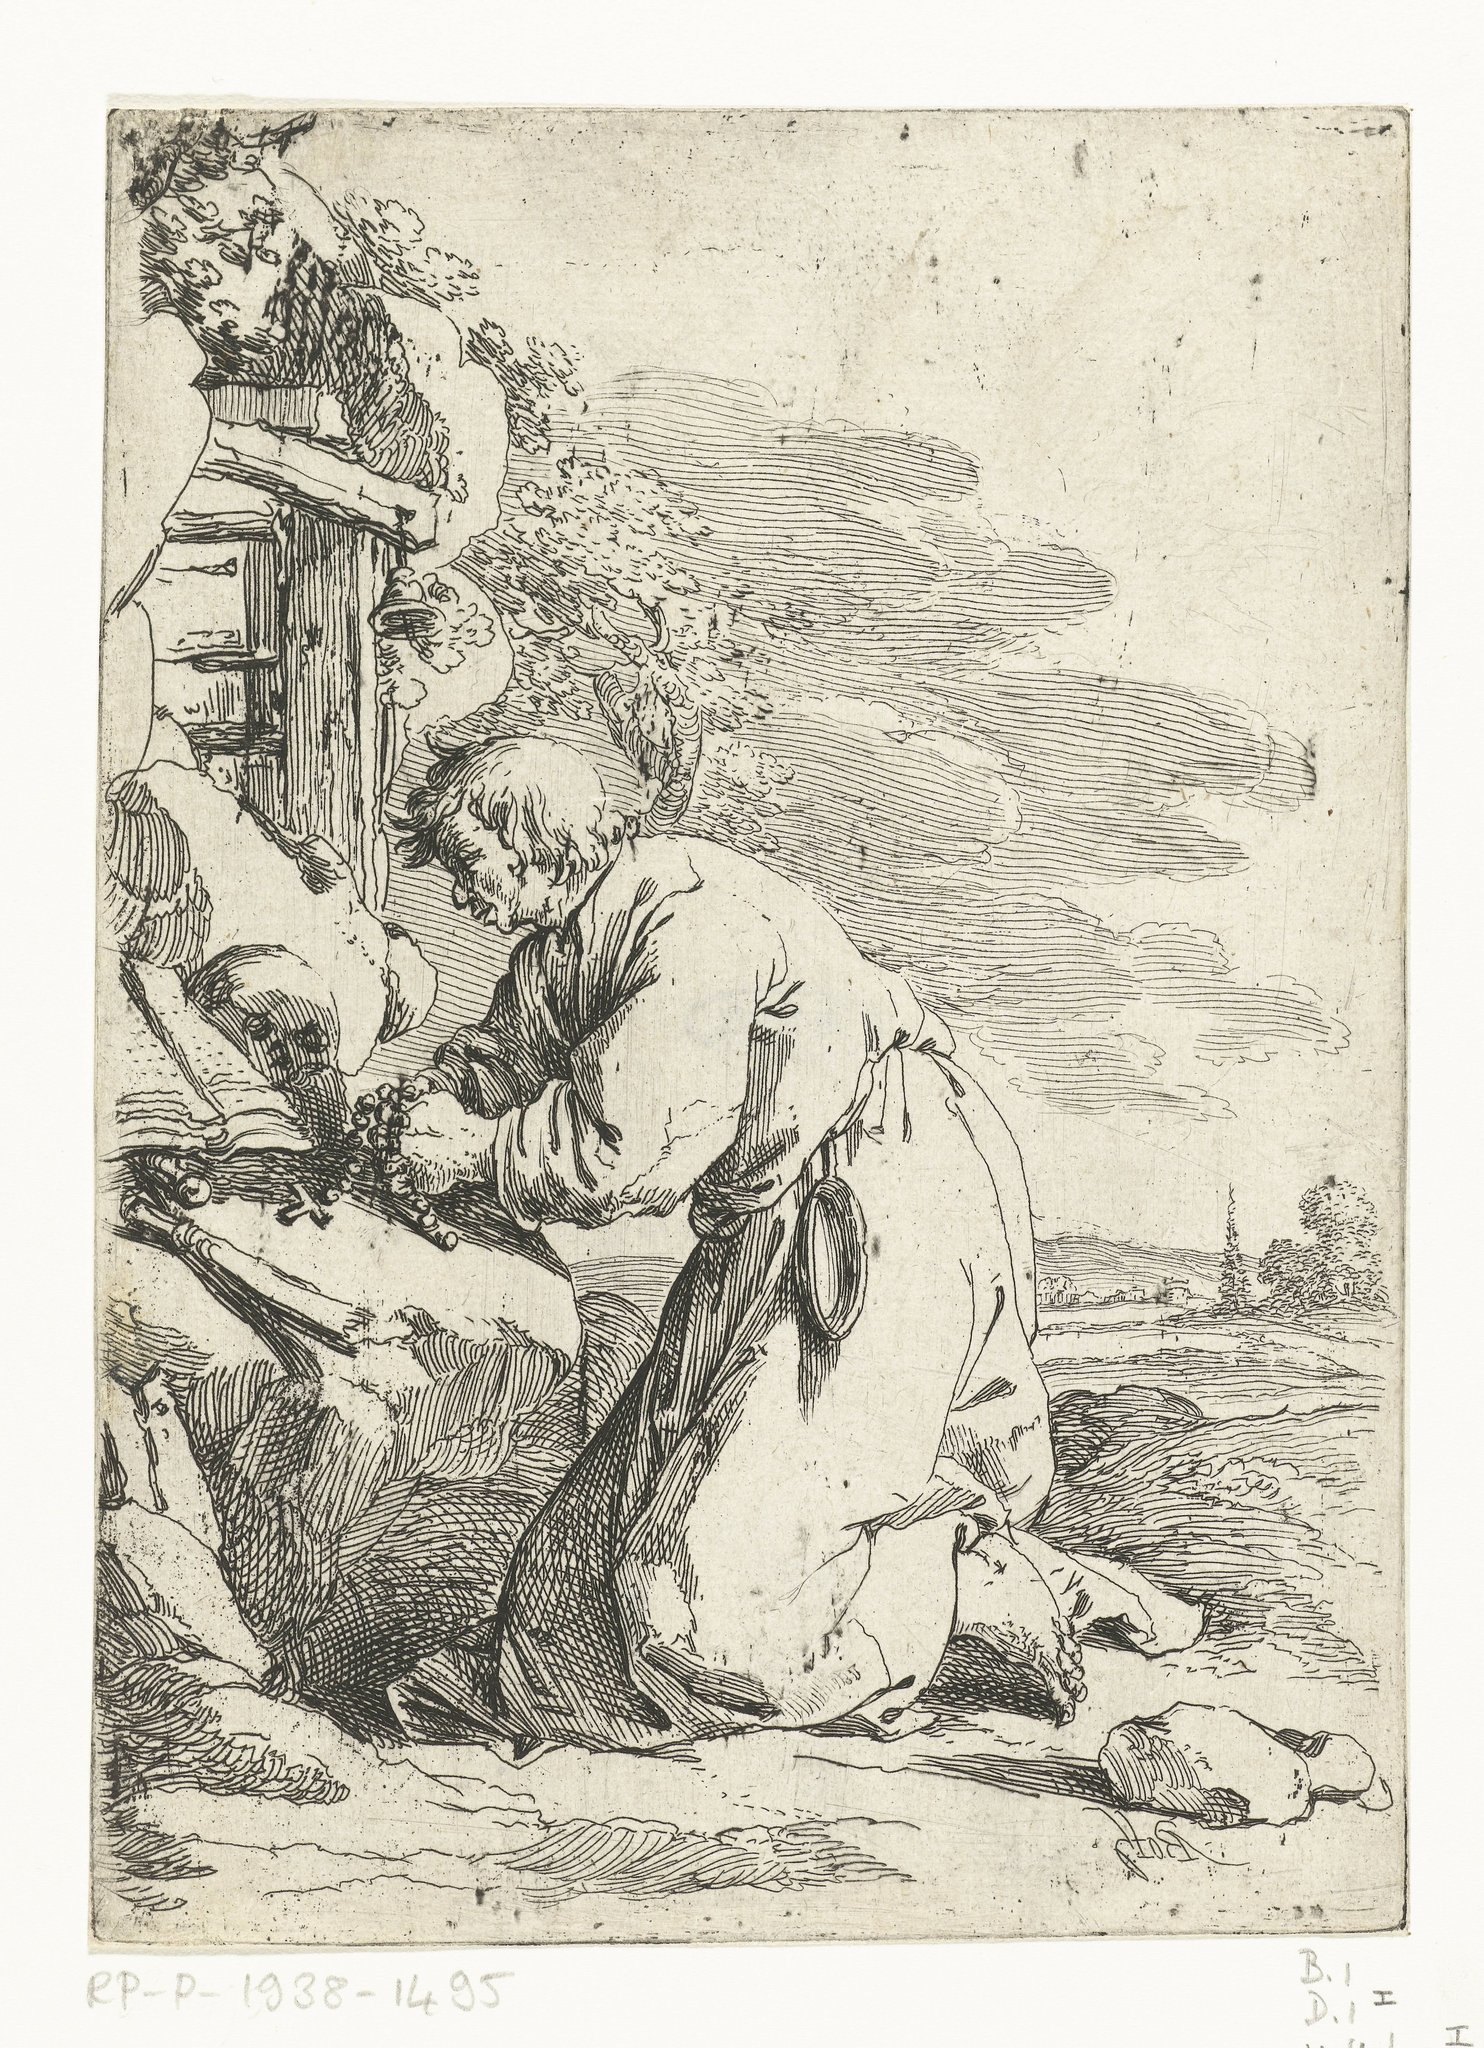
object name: print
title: Knielende kluizenaar in gebed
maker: andries both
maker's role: draughtsman, painter, print maker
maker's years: 1612-1642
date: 1622-1642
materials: paper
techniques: engraving, etching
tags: anchorite, hermit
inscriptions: collector's mark: Lugt 2228, collector's mark: Lugt 2760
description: Een kluizenaar bidt voor zijn kluis. Hij houdt een rozenkrans vast en leunt tegen een rots.